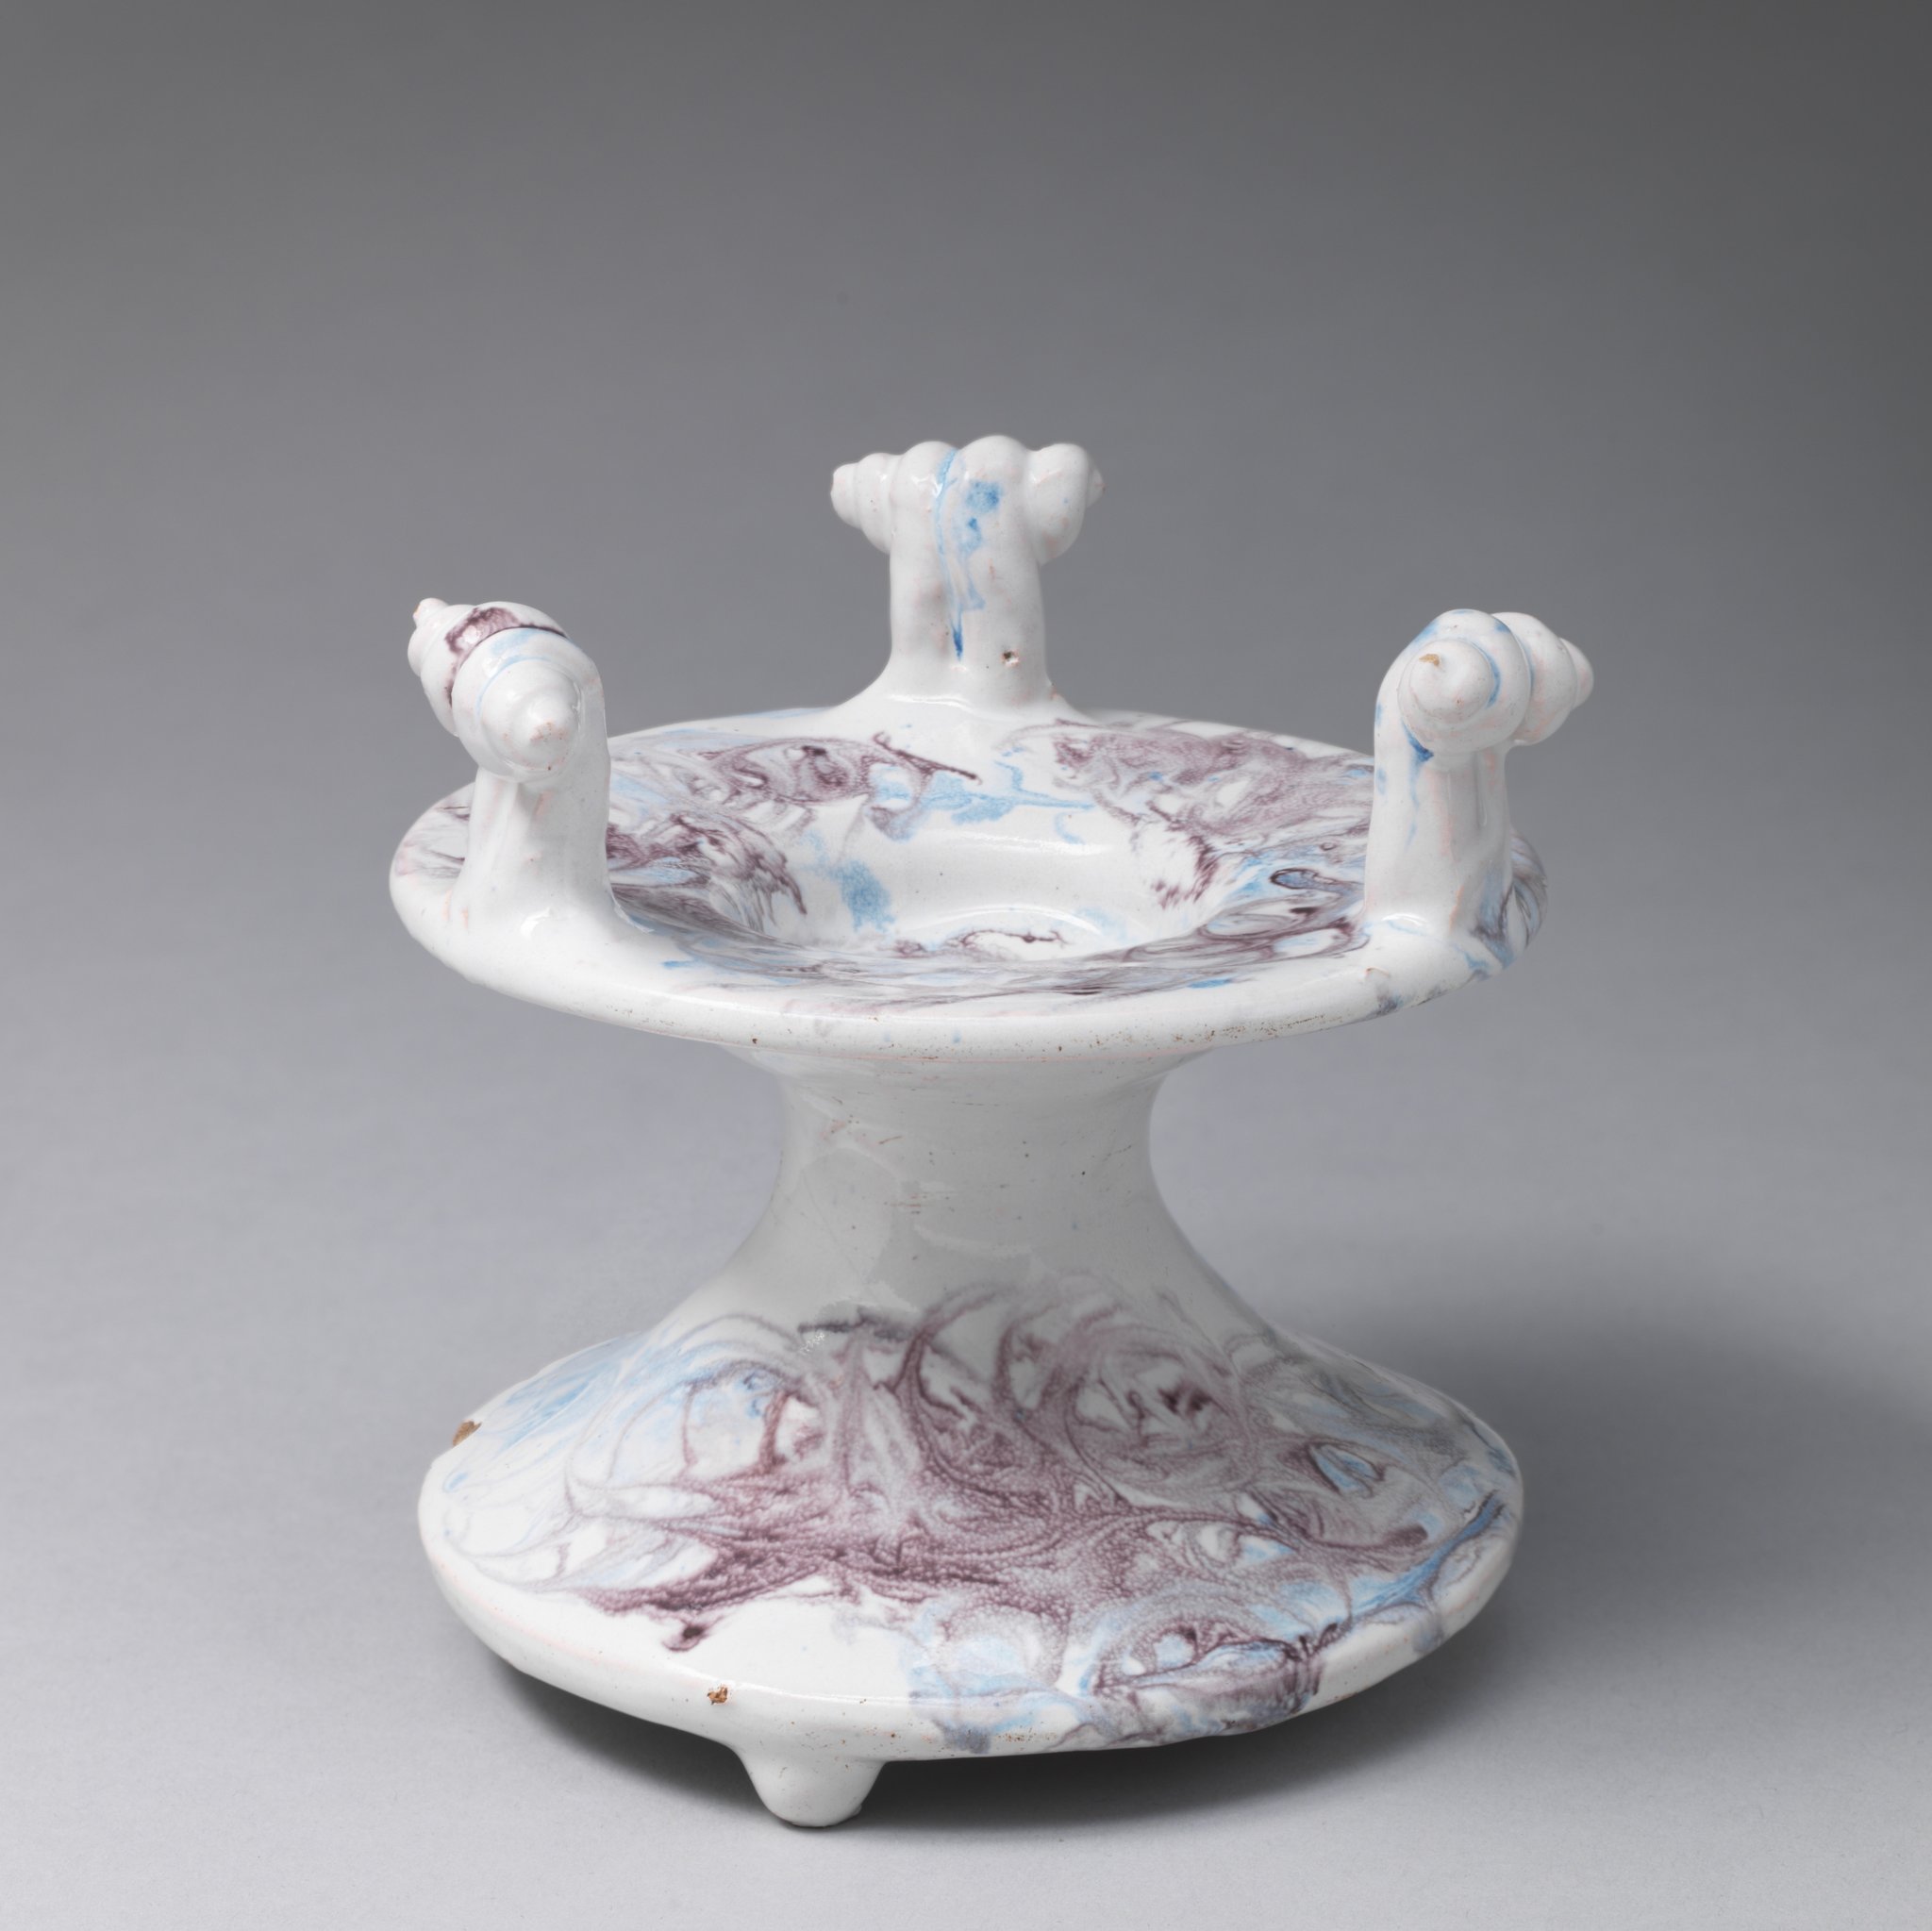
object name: salt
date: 1601-1700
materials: earthenware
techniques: glazing